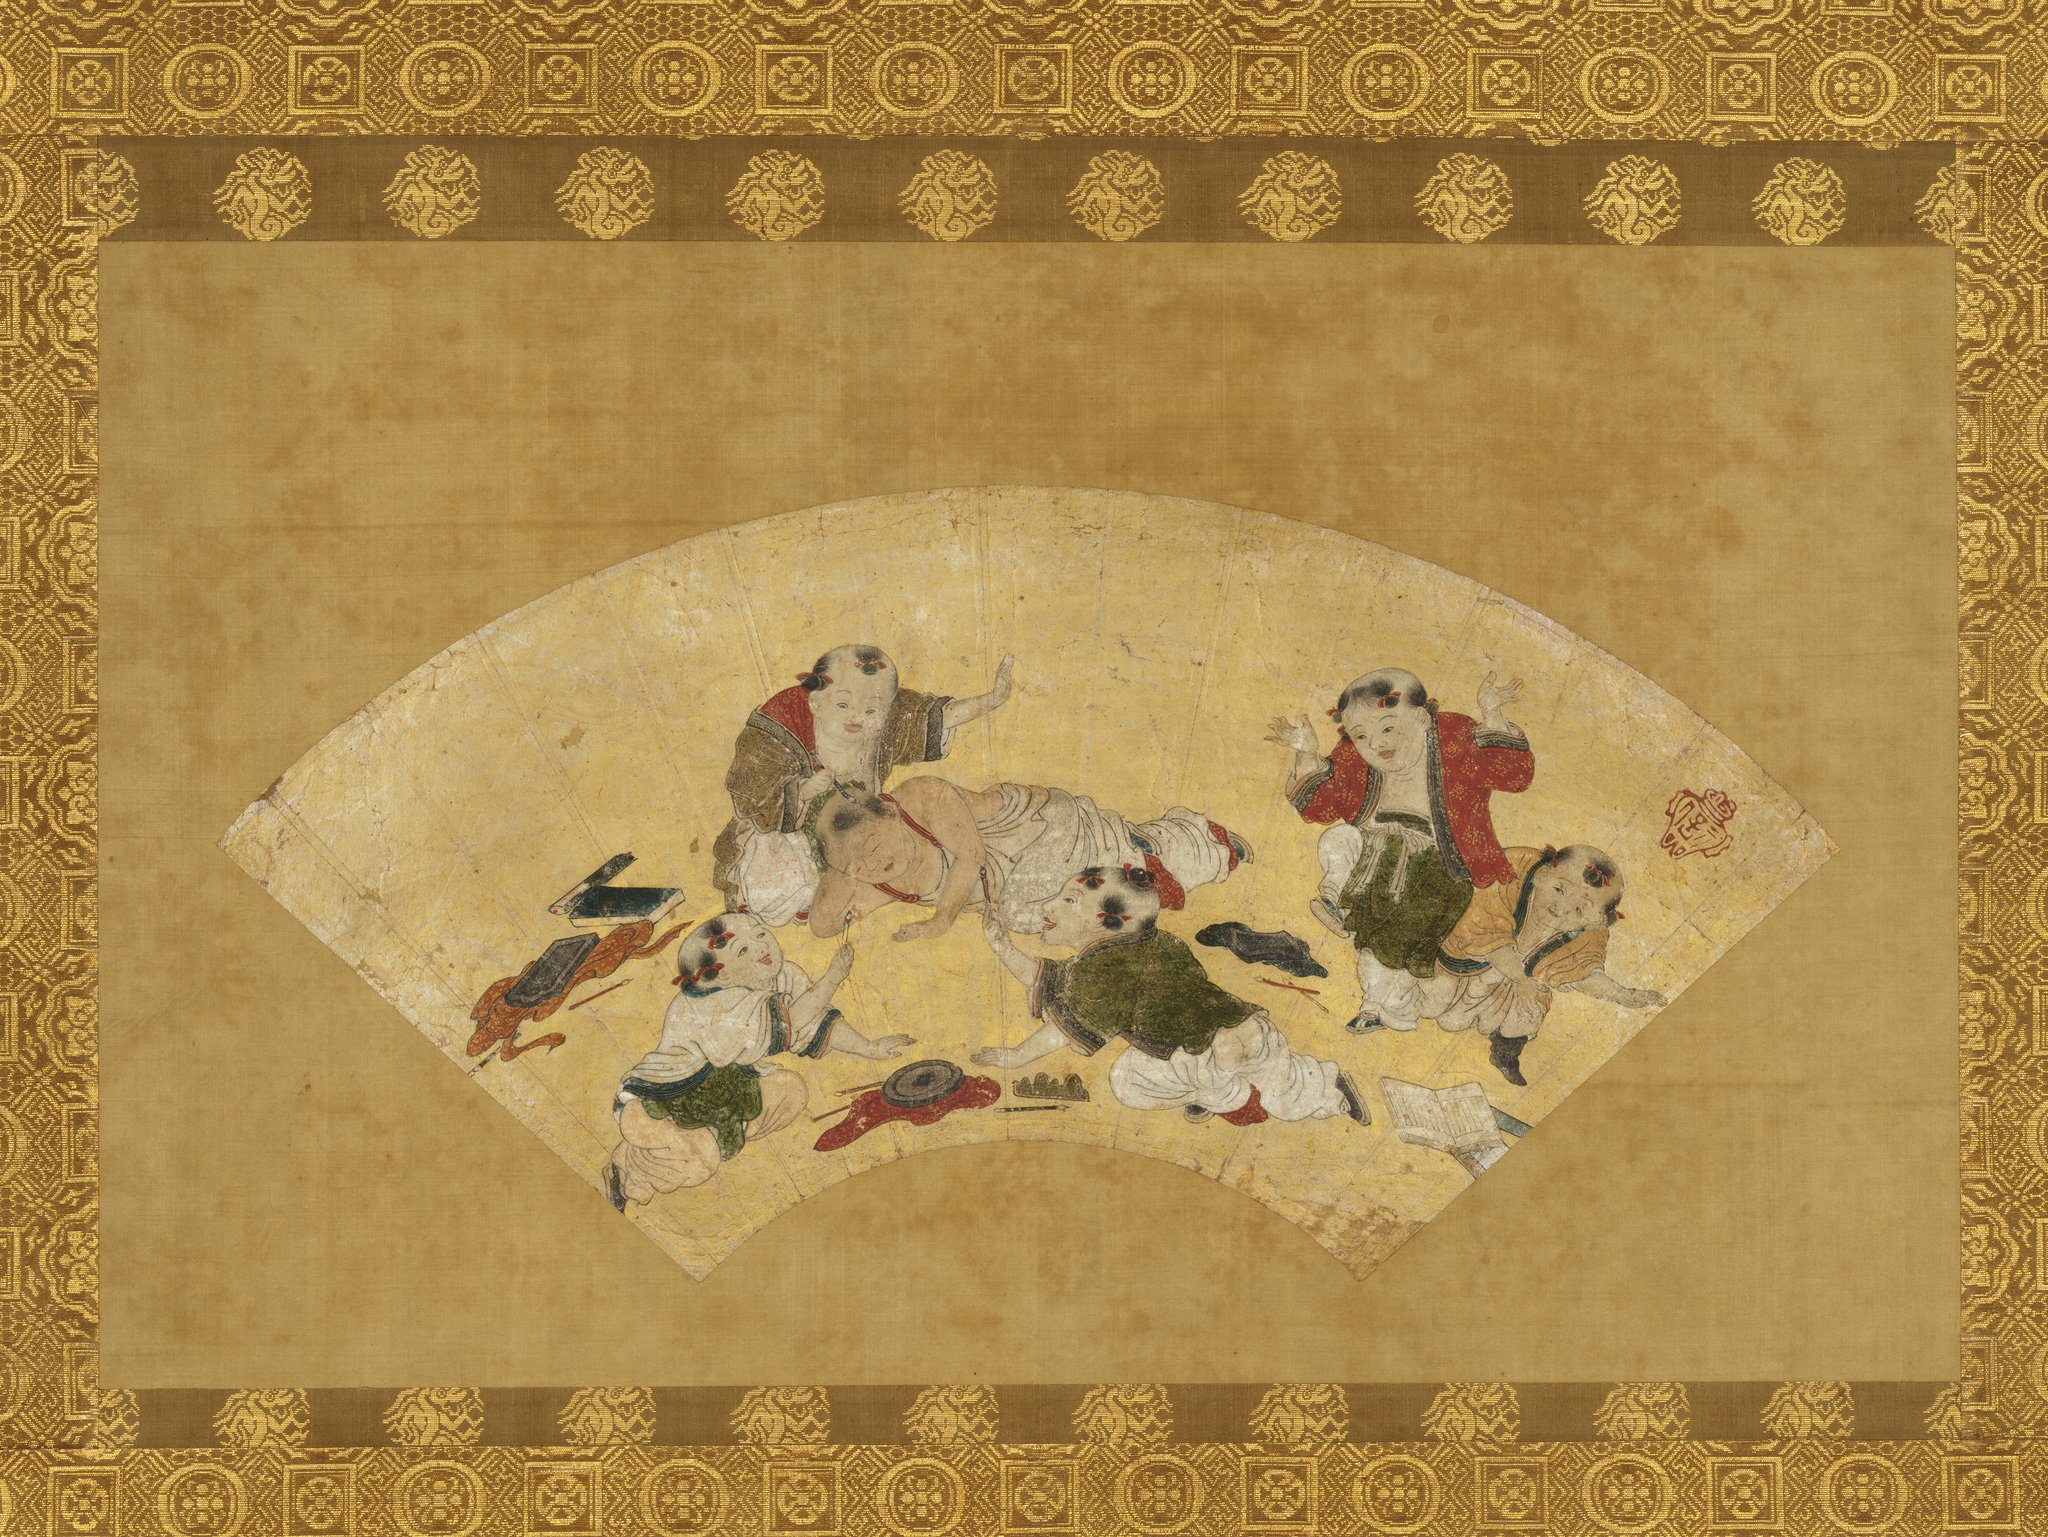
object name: hanging scroll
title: Chinese Boys at Play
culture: japanese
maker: kano motonobu 狩野元信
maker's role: artist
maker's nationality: japanese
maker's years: 1477-1559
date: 1501-1550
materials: gold, ink, mica, paper